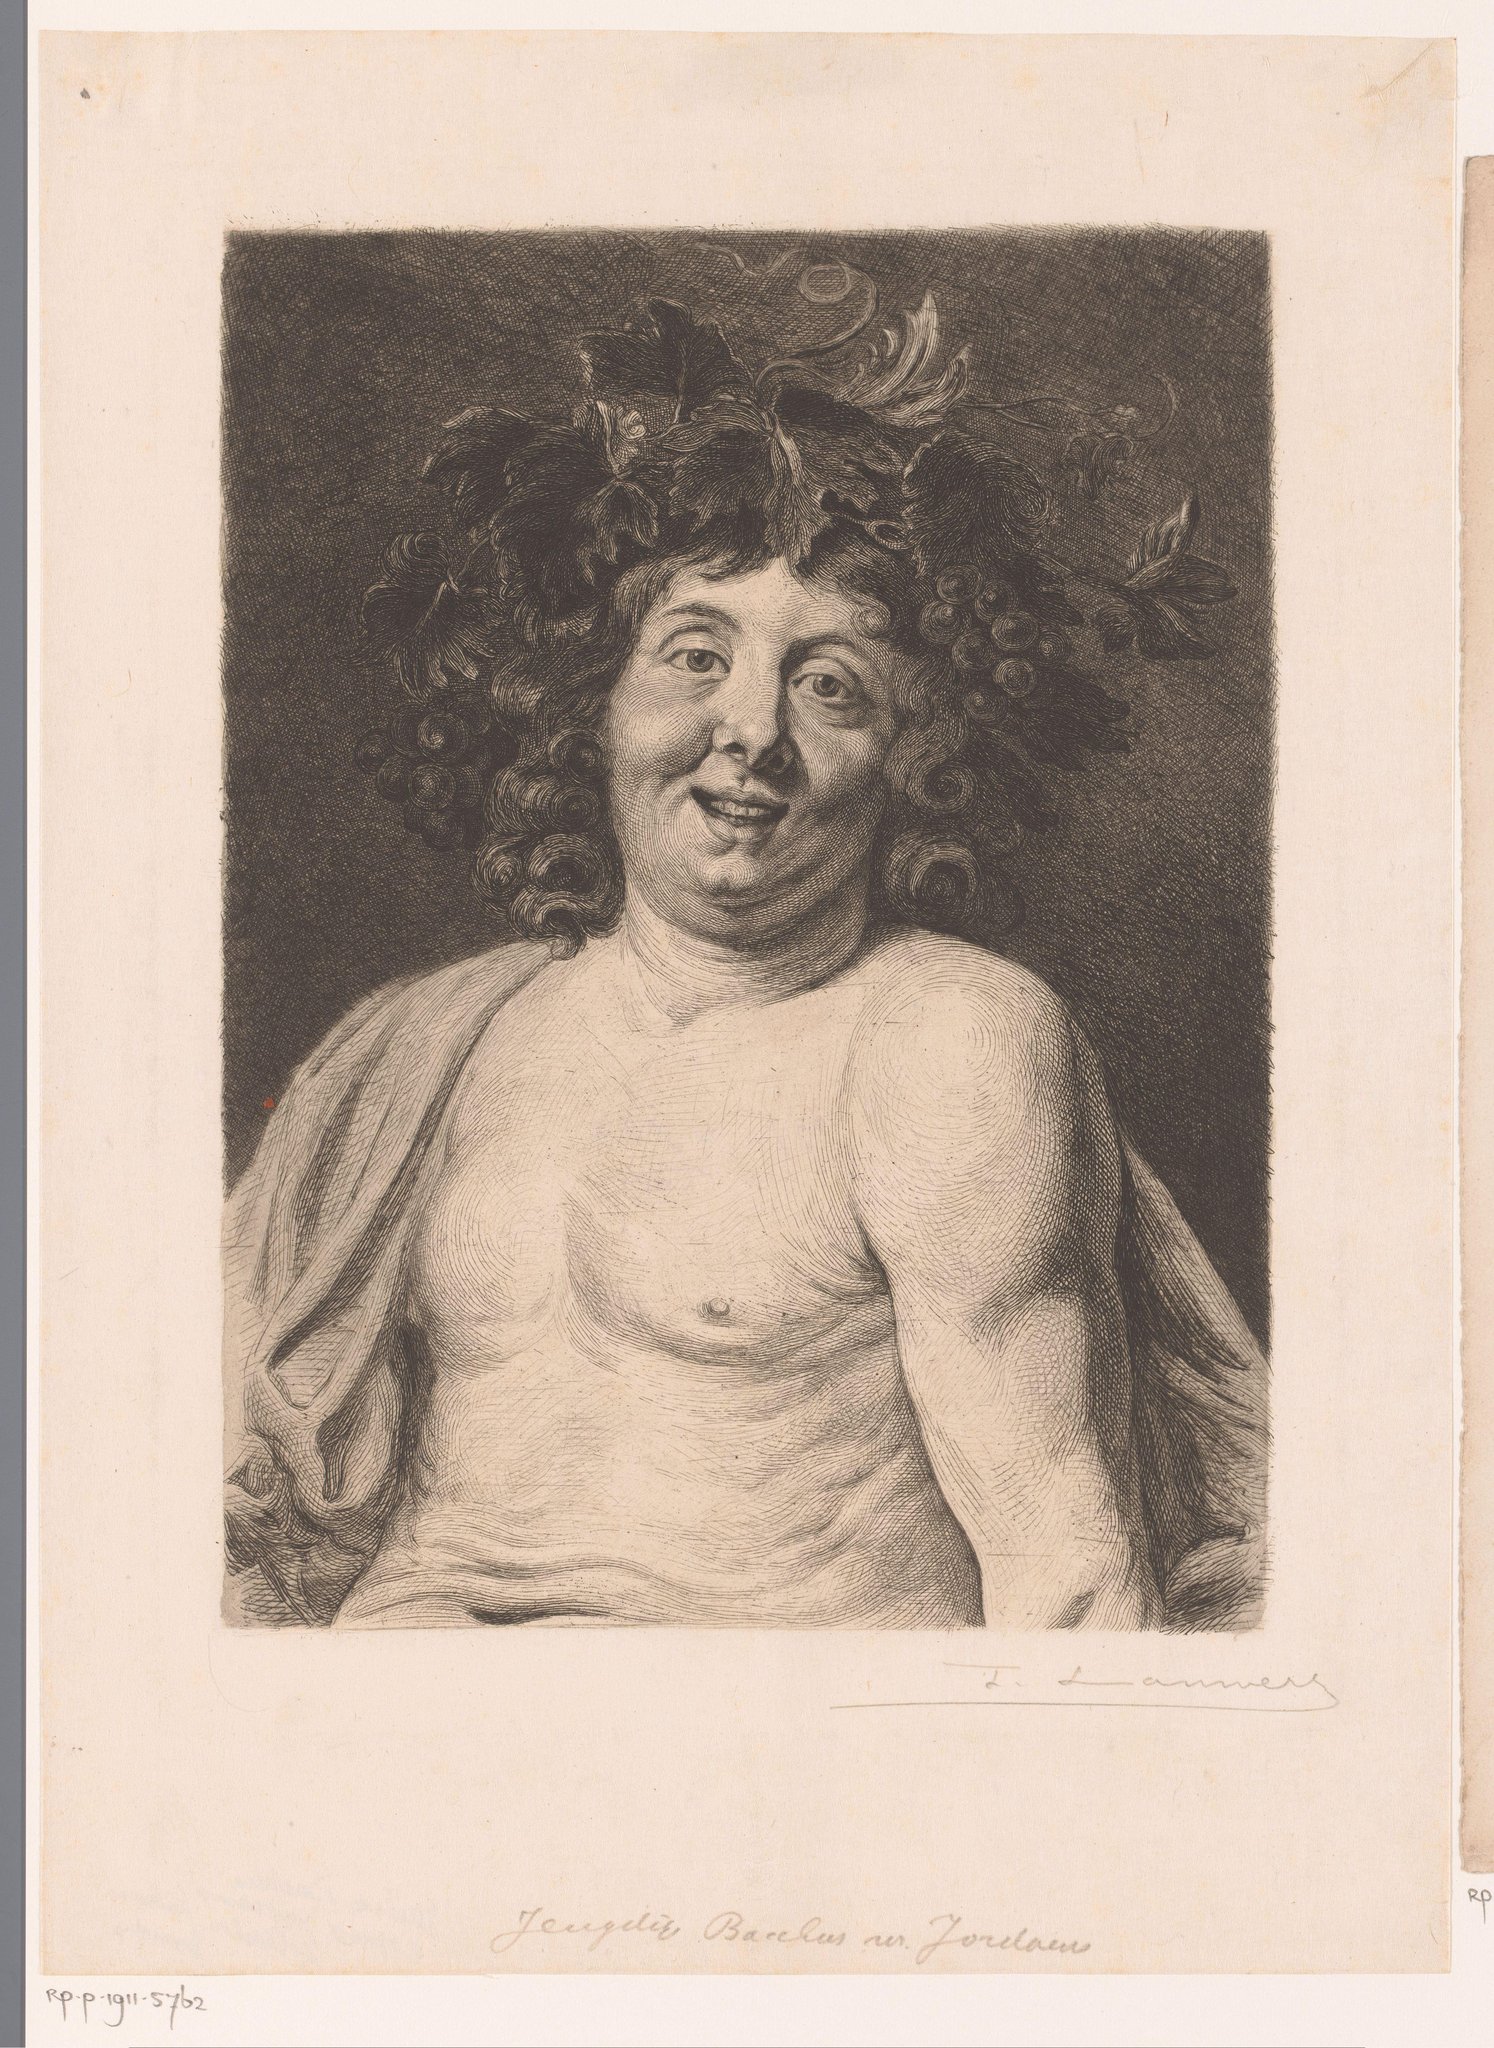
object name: print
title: Jonge visser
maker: frans lauwers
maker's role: print maker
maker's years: 1854-1931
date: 1864-1911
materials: paper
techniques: drypoint, etching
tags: fisherman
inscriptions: collector's mark: Lugt 2228